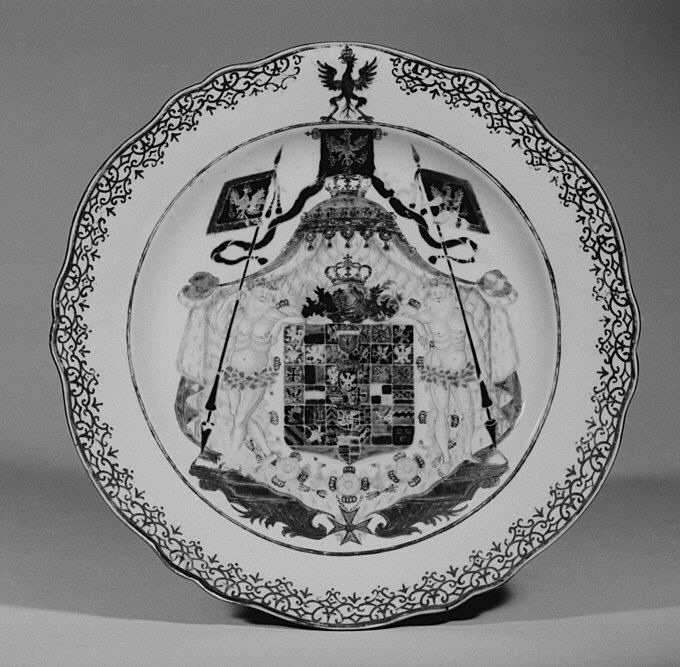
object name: plate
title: Plate (one of two)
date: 1750-1755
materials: hard paste porcelain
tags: coat of arms